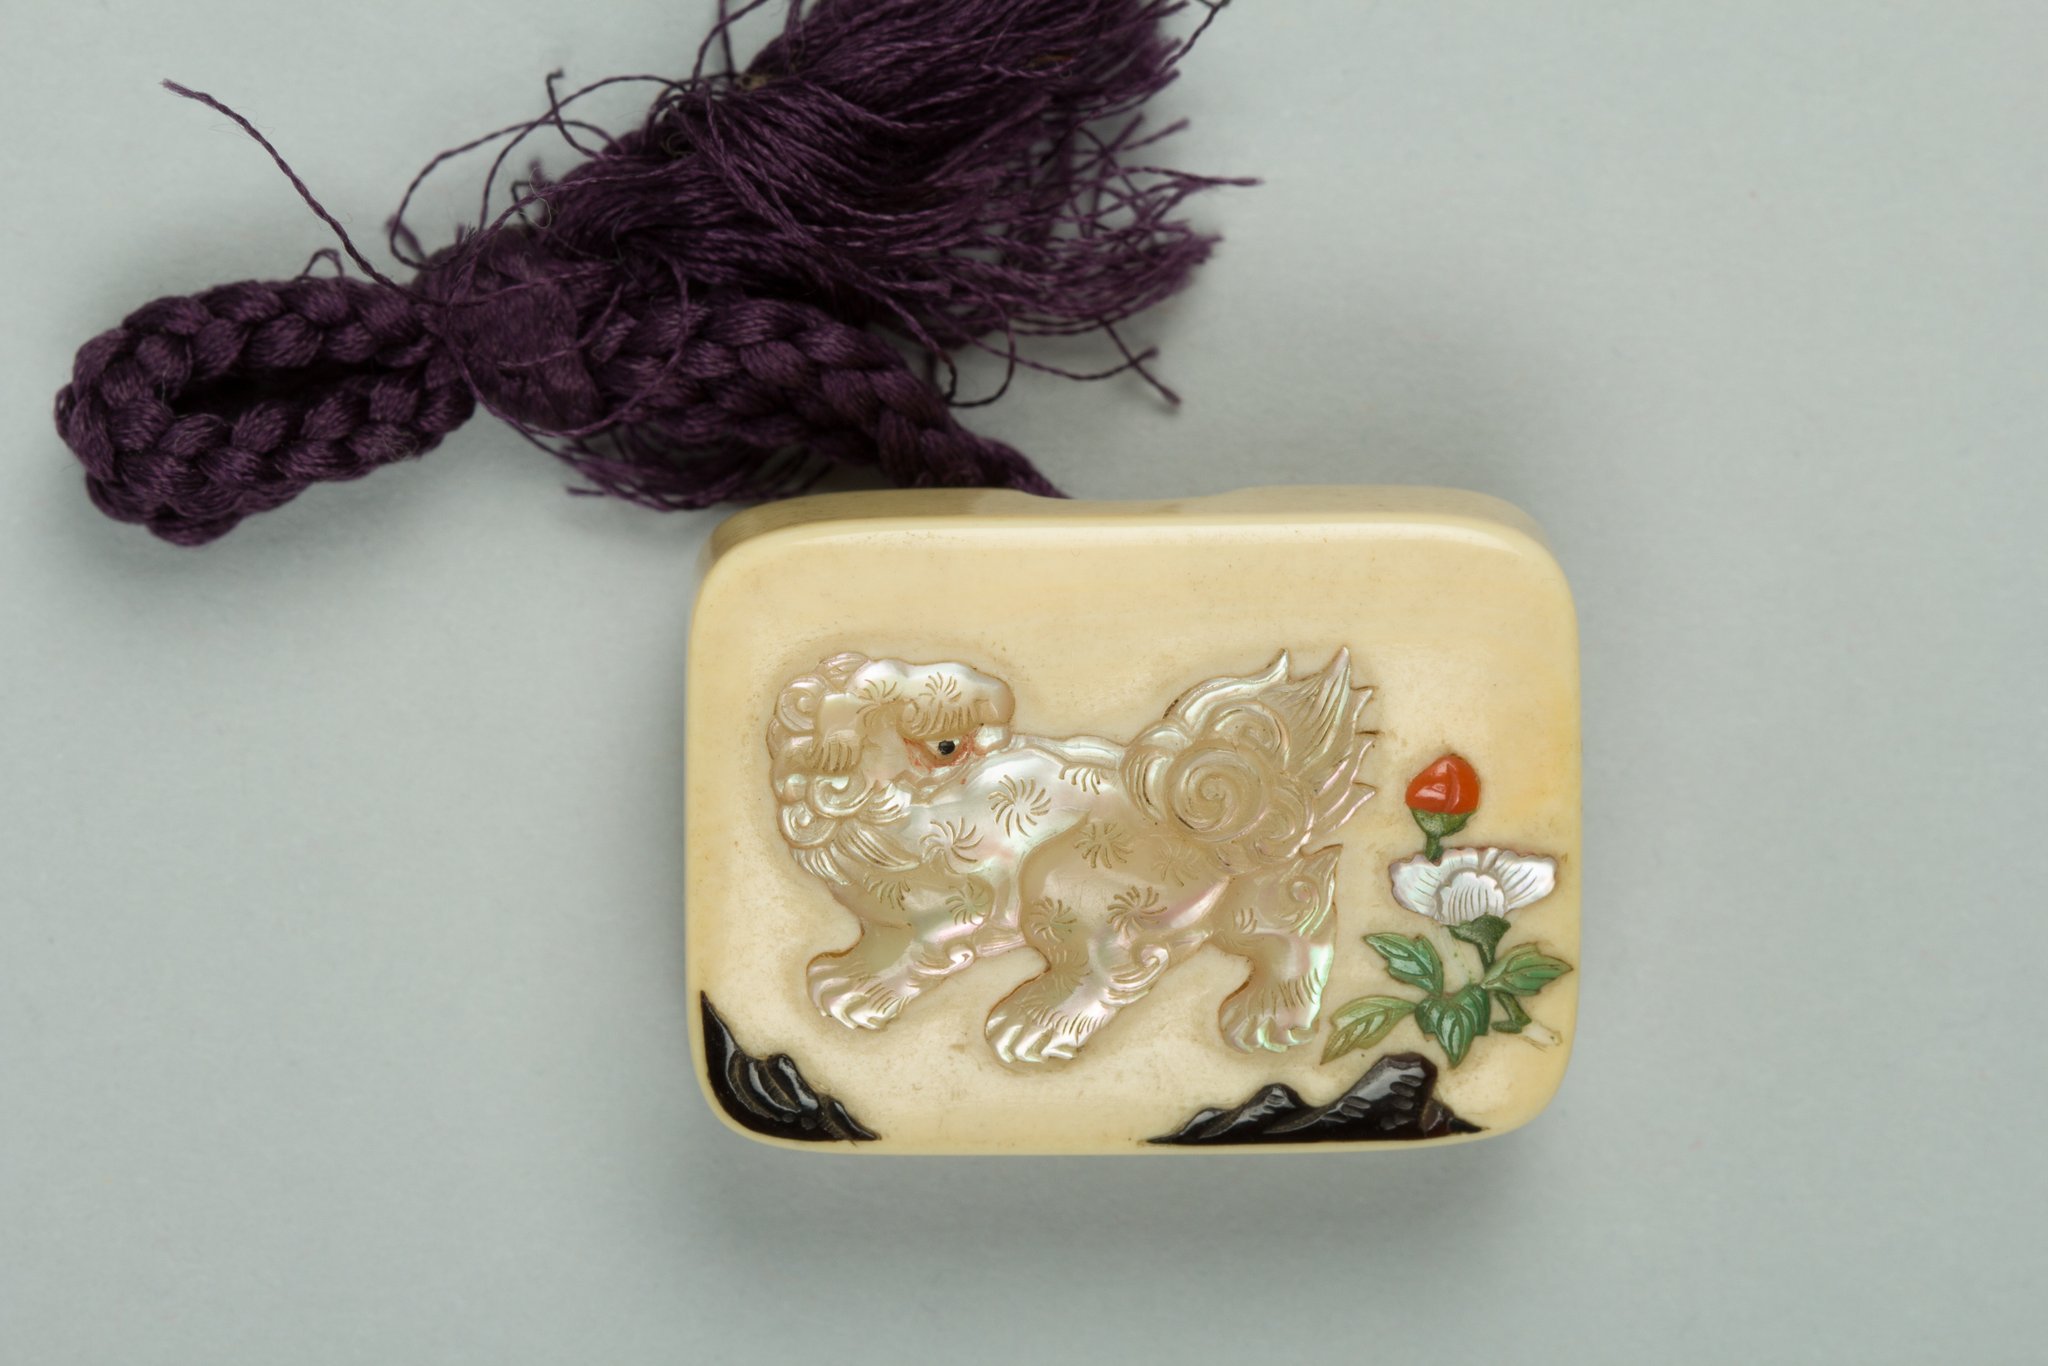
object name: netsuke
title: Netsuke of Miniature Box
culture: japanese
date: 1801-1900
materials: ivory, mother of pearl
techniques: inlay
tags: mythical creatures